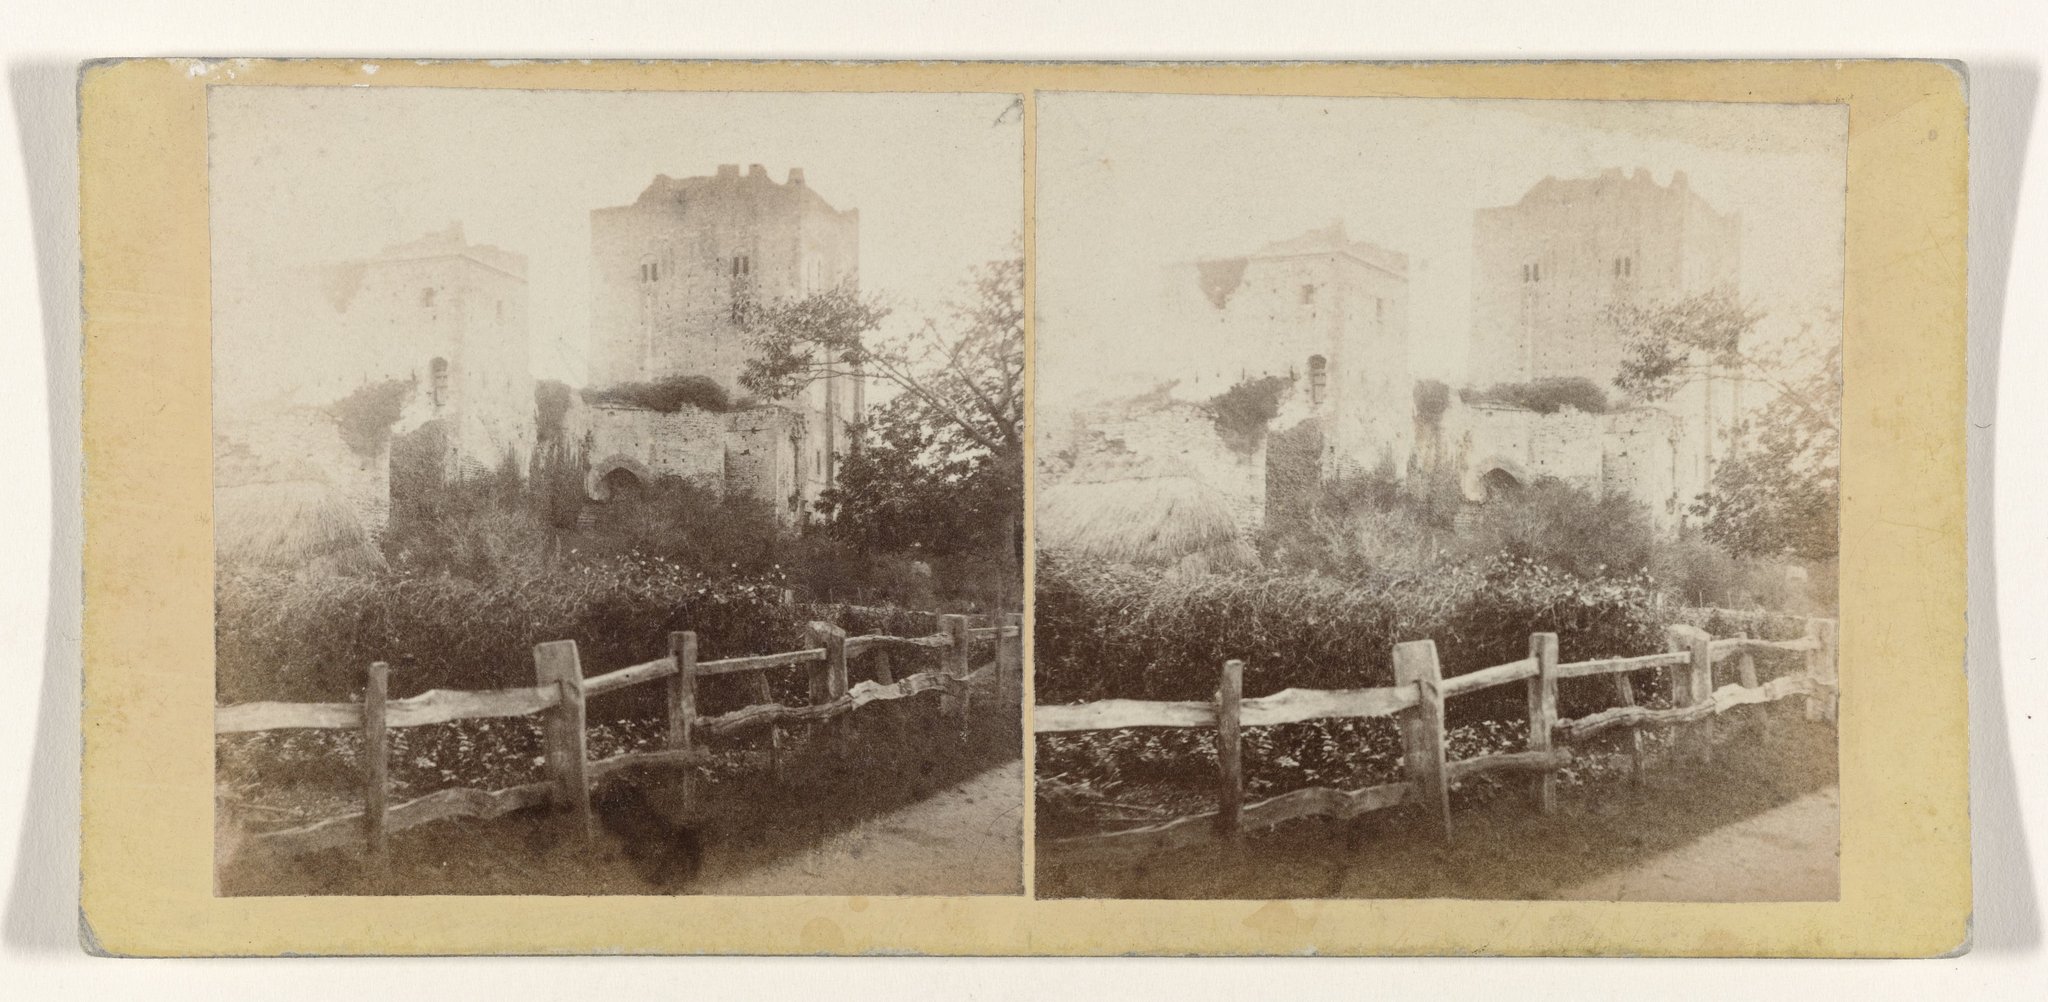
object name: stereograph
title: Ruïnes van het Portchester Castle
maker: william bartholomew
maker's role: fotograaf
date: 1810-1860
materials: cardboard, paper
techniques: albumen print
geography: portchester castle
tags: ruin of a dwelling, house, castle, etc.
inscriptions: inscription: ‘Fothergill process - Oct 1860/ Bi-lens Camera - 38 stop/ sxp - 6 min./ From/ Wm Bartholomew/ Foxham [...]’